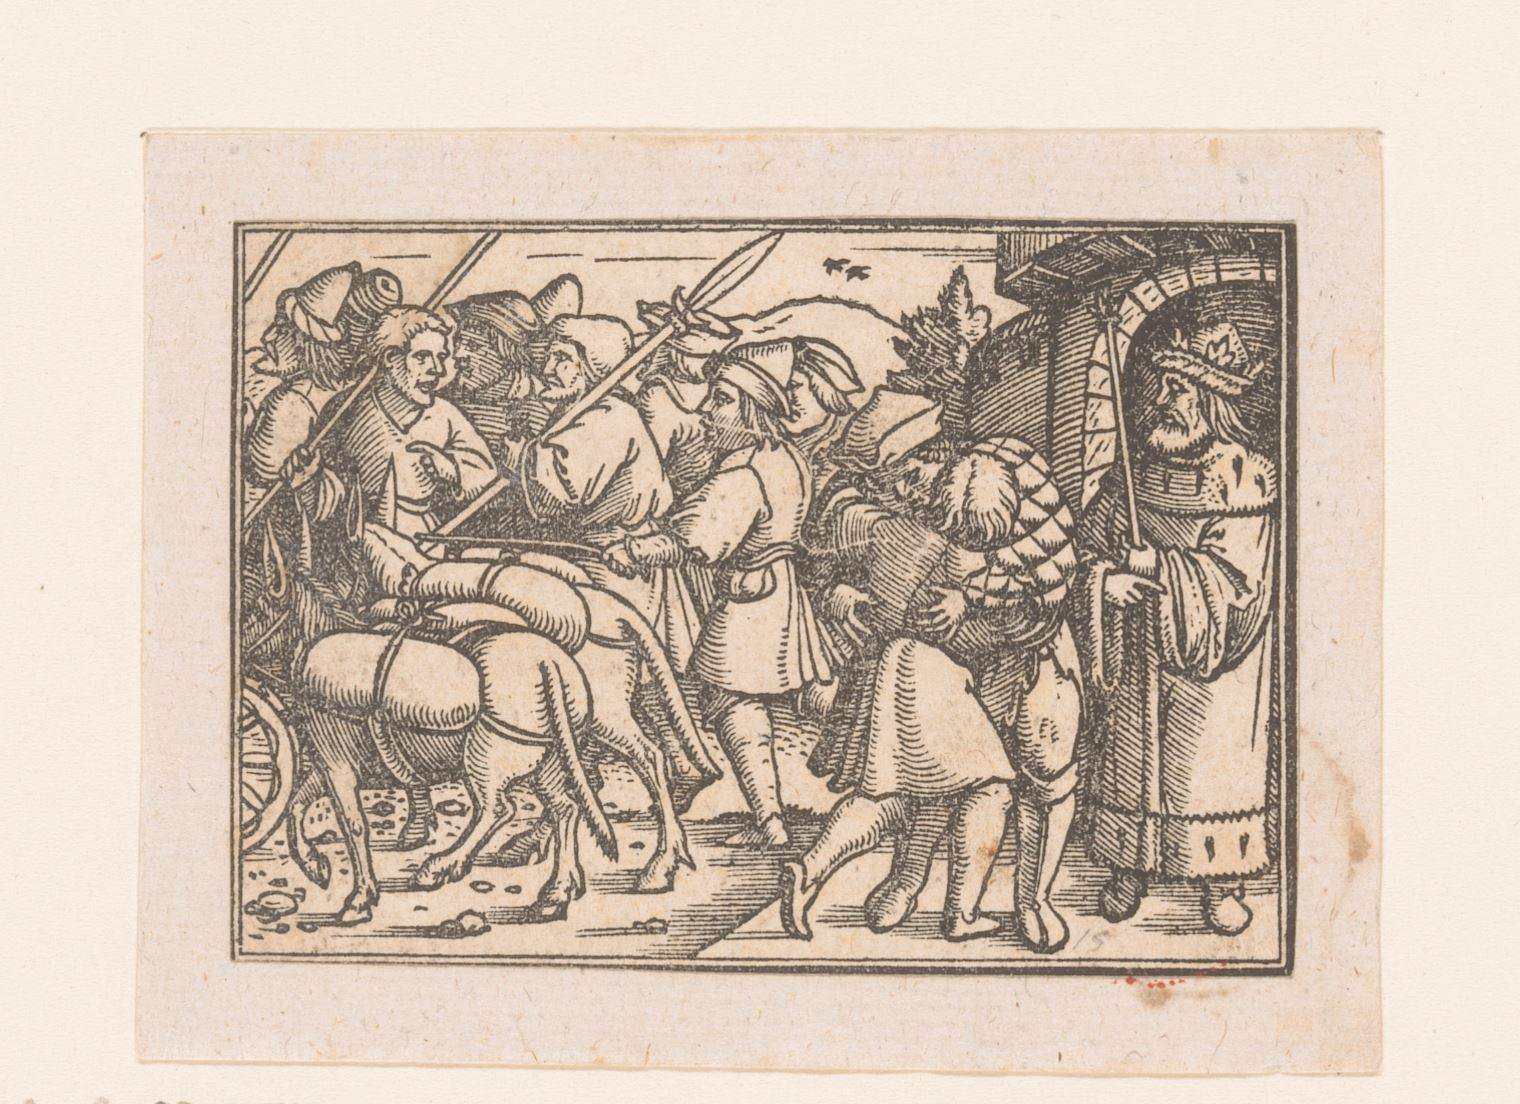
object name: print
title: Jozef verkoopt graan aan zijn broers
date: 1522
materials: paper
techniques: woodcut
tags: joseph's brothers load their donkeys and leave egypt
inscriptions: collector's mark: Lugt 240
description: Mogelijk een kopie van een prent van Hans Holbein de jongere. Niet uit de Icones historiarum Veteris Testamenti van 1538. Deze kopie mogelijk uit: Biblia sacra iuxta vulgatam. Parijs: Jean Benoît, 1552. Ook aanwezig in de Herzog August Bibliothek: http://diglib.hab.de?grafik=graph-res-d-326-1.